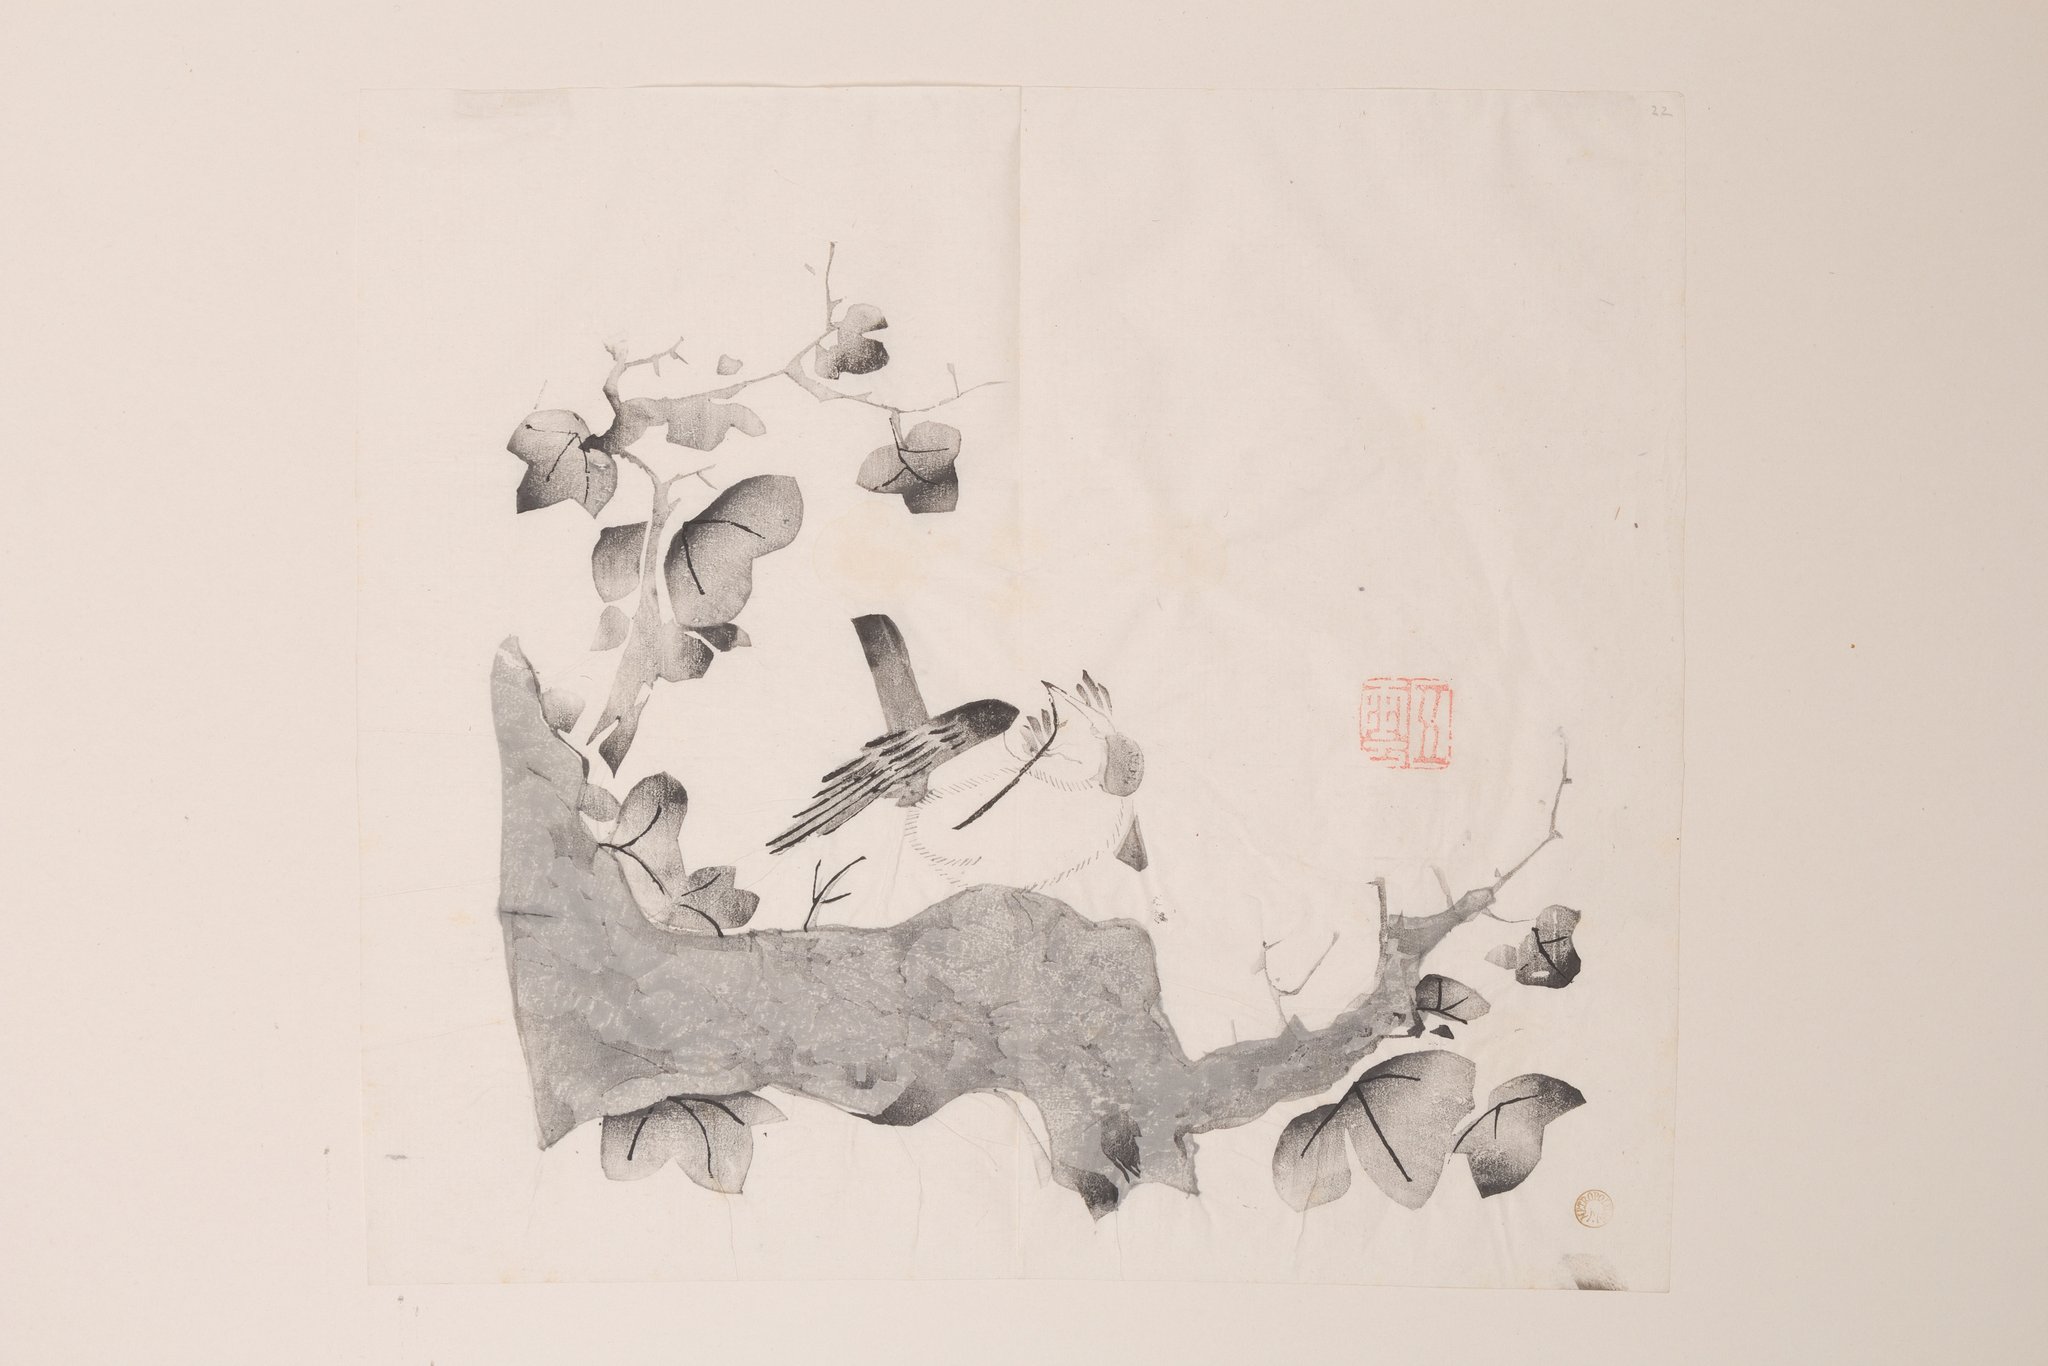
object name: print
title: Page from Shi Zhu Zhai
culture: chinese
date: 1736-1795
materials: ink, paper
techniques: polychrome, woodblock print